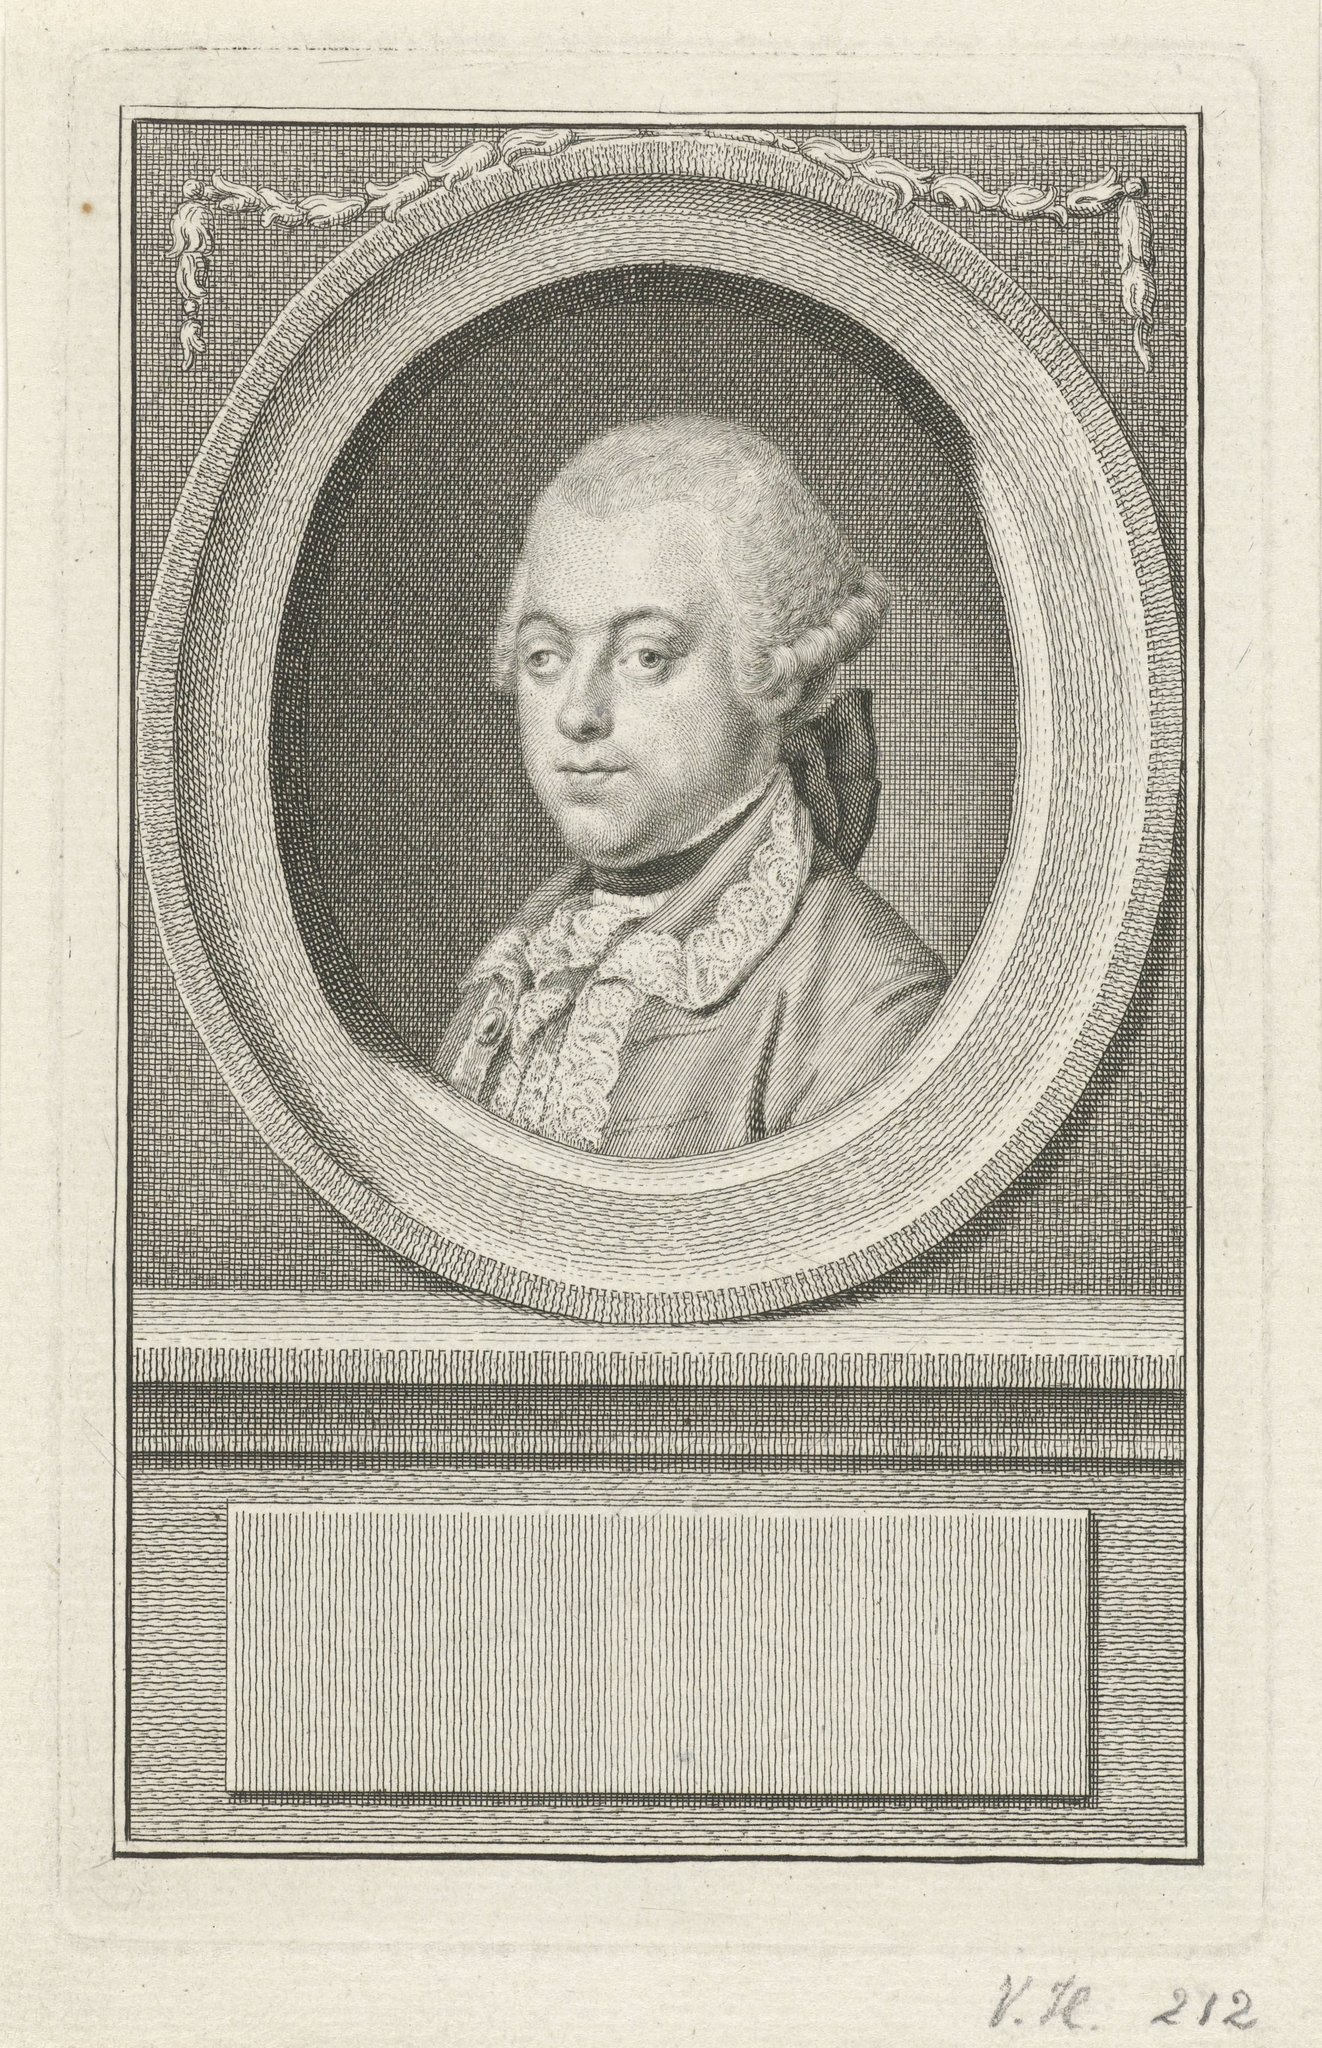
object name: print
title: Portret van Gerrit Hooft junior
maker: jacob houbraken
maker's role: draughtsman, print maker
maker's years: 1698-1780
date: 1767-1769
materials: paper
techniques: engraving, etching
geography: amsterdam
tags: dichter, gerrit hooft junior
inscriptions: collector's mark: Lugt 2228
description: Proefdruk van de prent volgens Ver Huell gebruikt in: Gerardus Hooft junior [bewerkt door Jeronimo de Bosch], Poëmata. Amsterdam: César Noel Guerin, 1770.